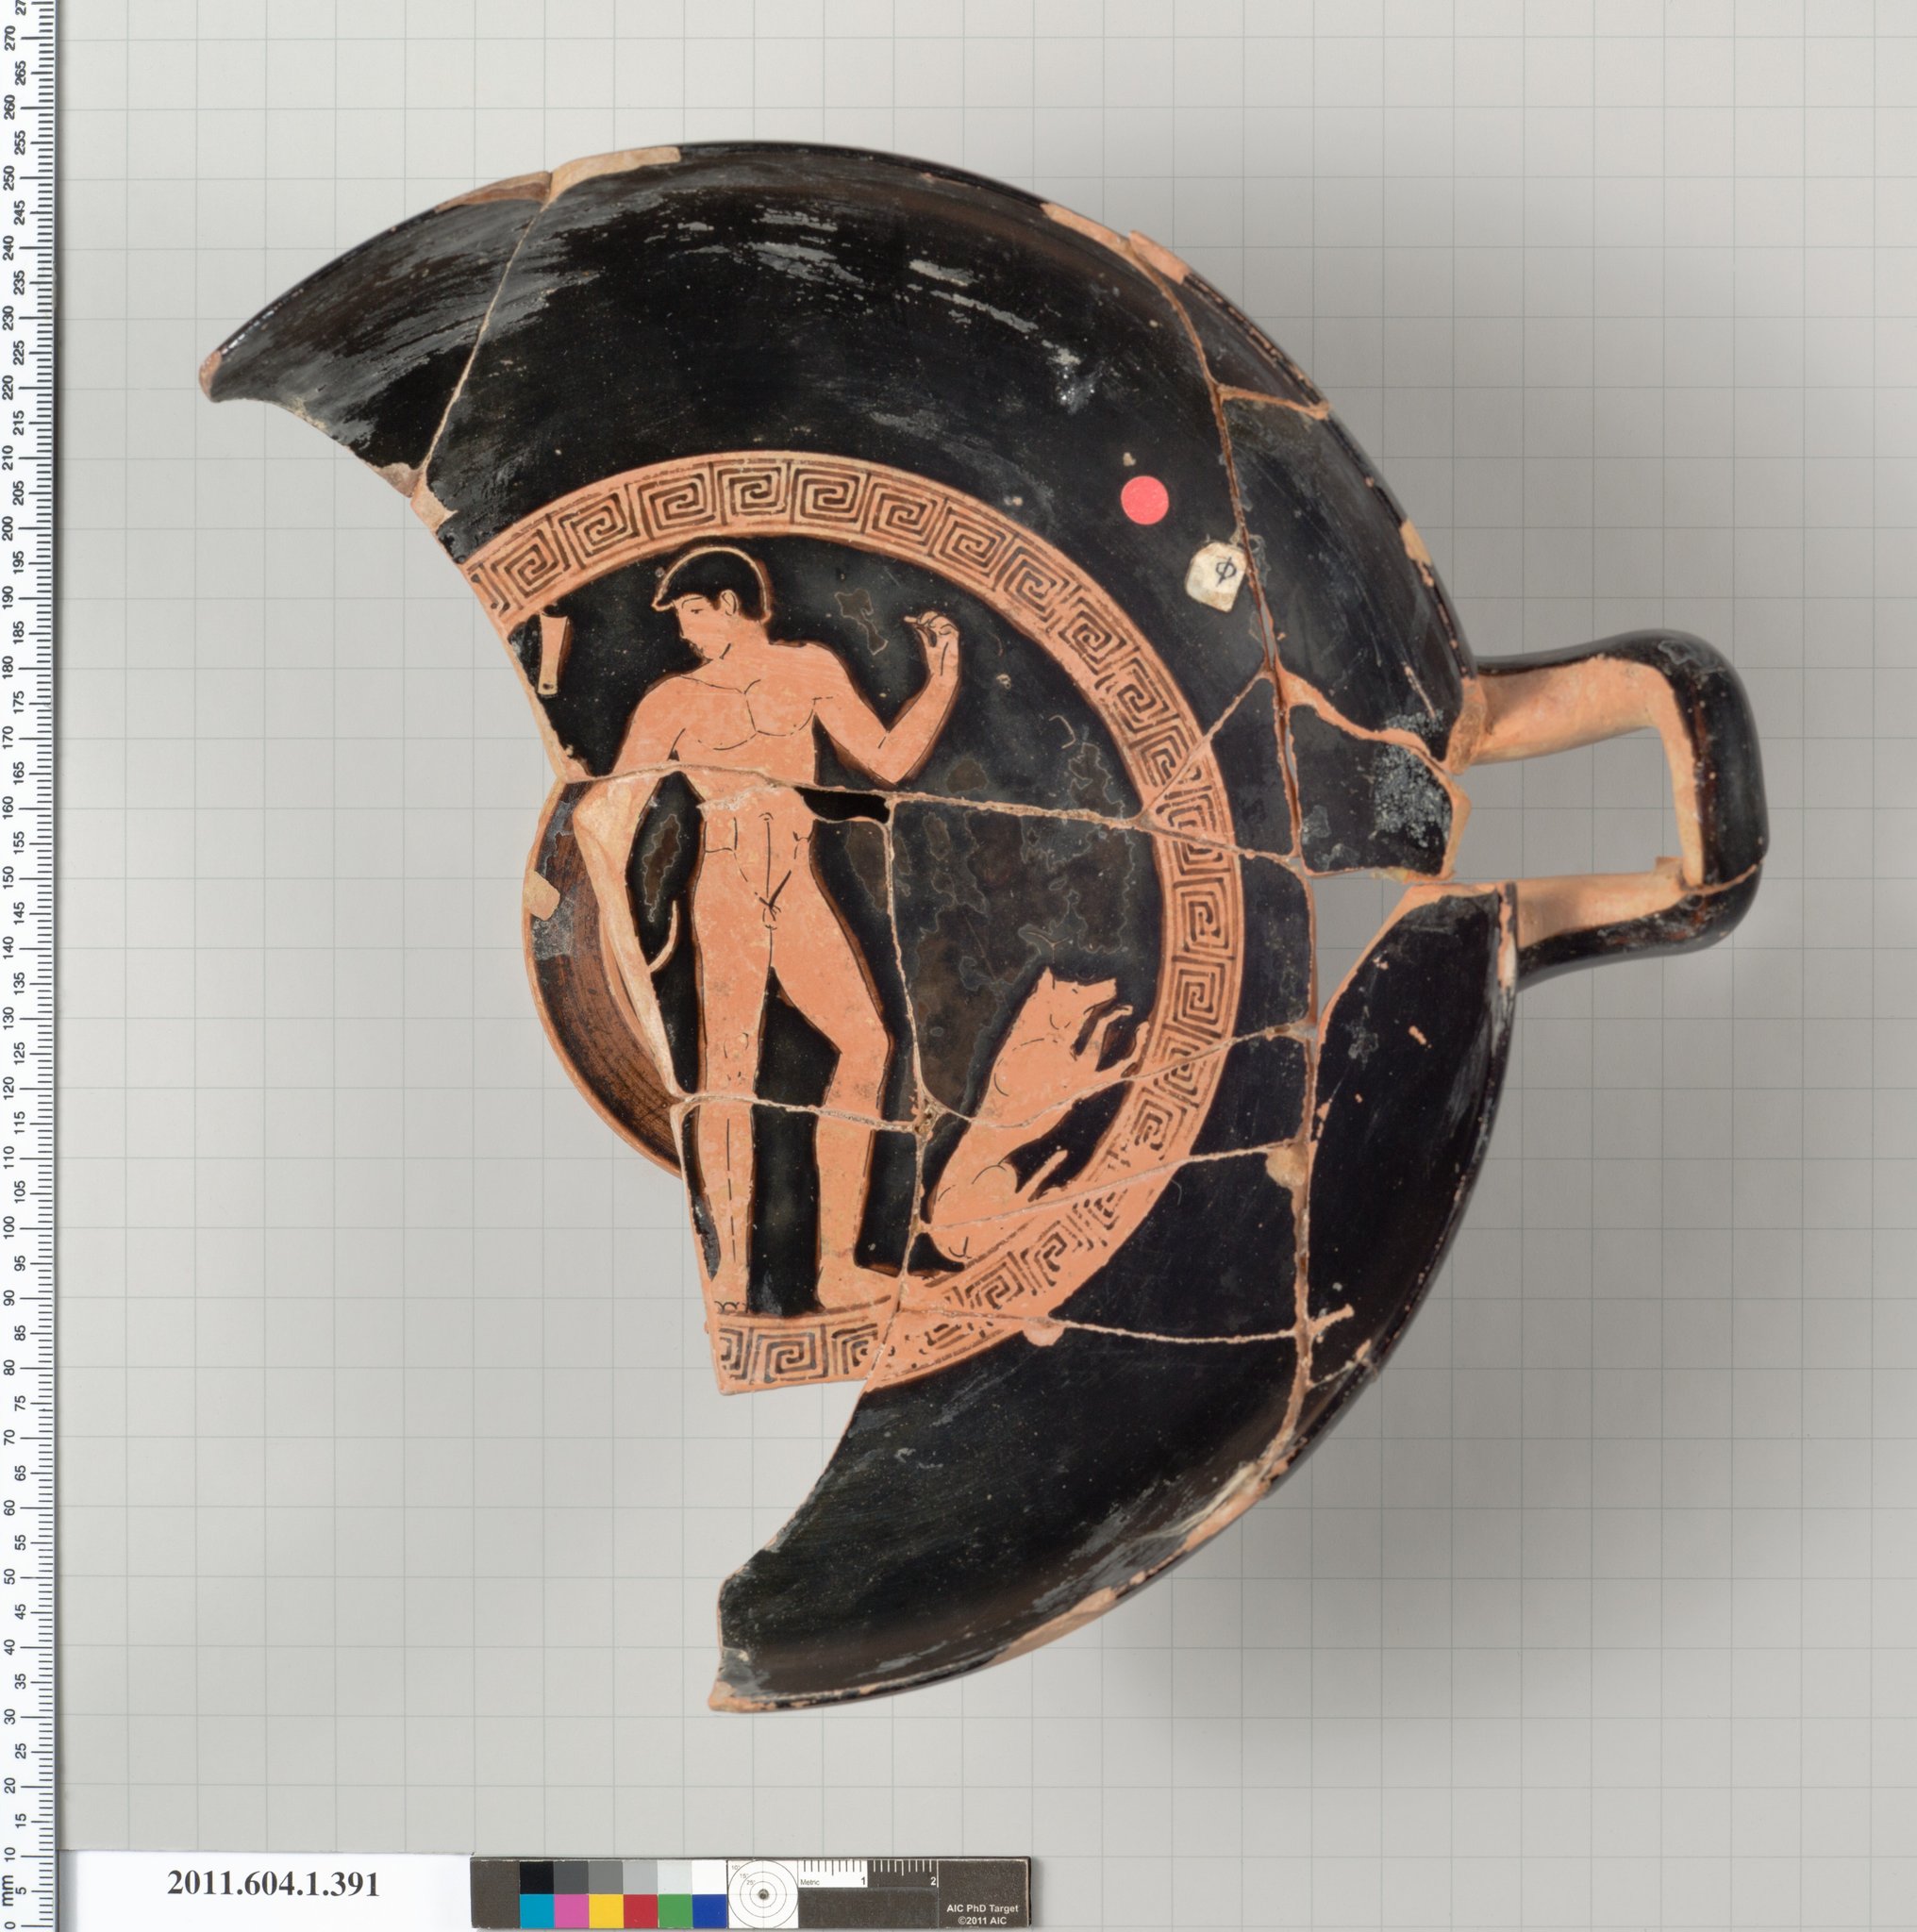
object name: kylix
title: Terracotta kylix (drinking cup)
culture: greek, attic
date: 475-451 BCE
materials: terracotta